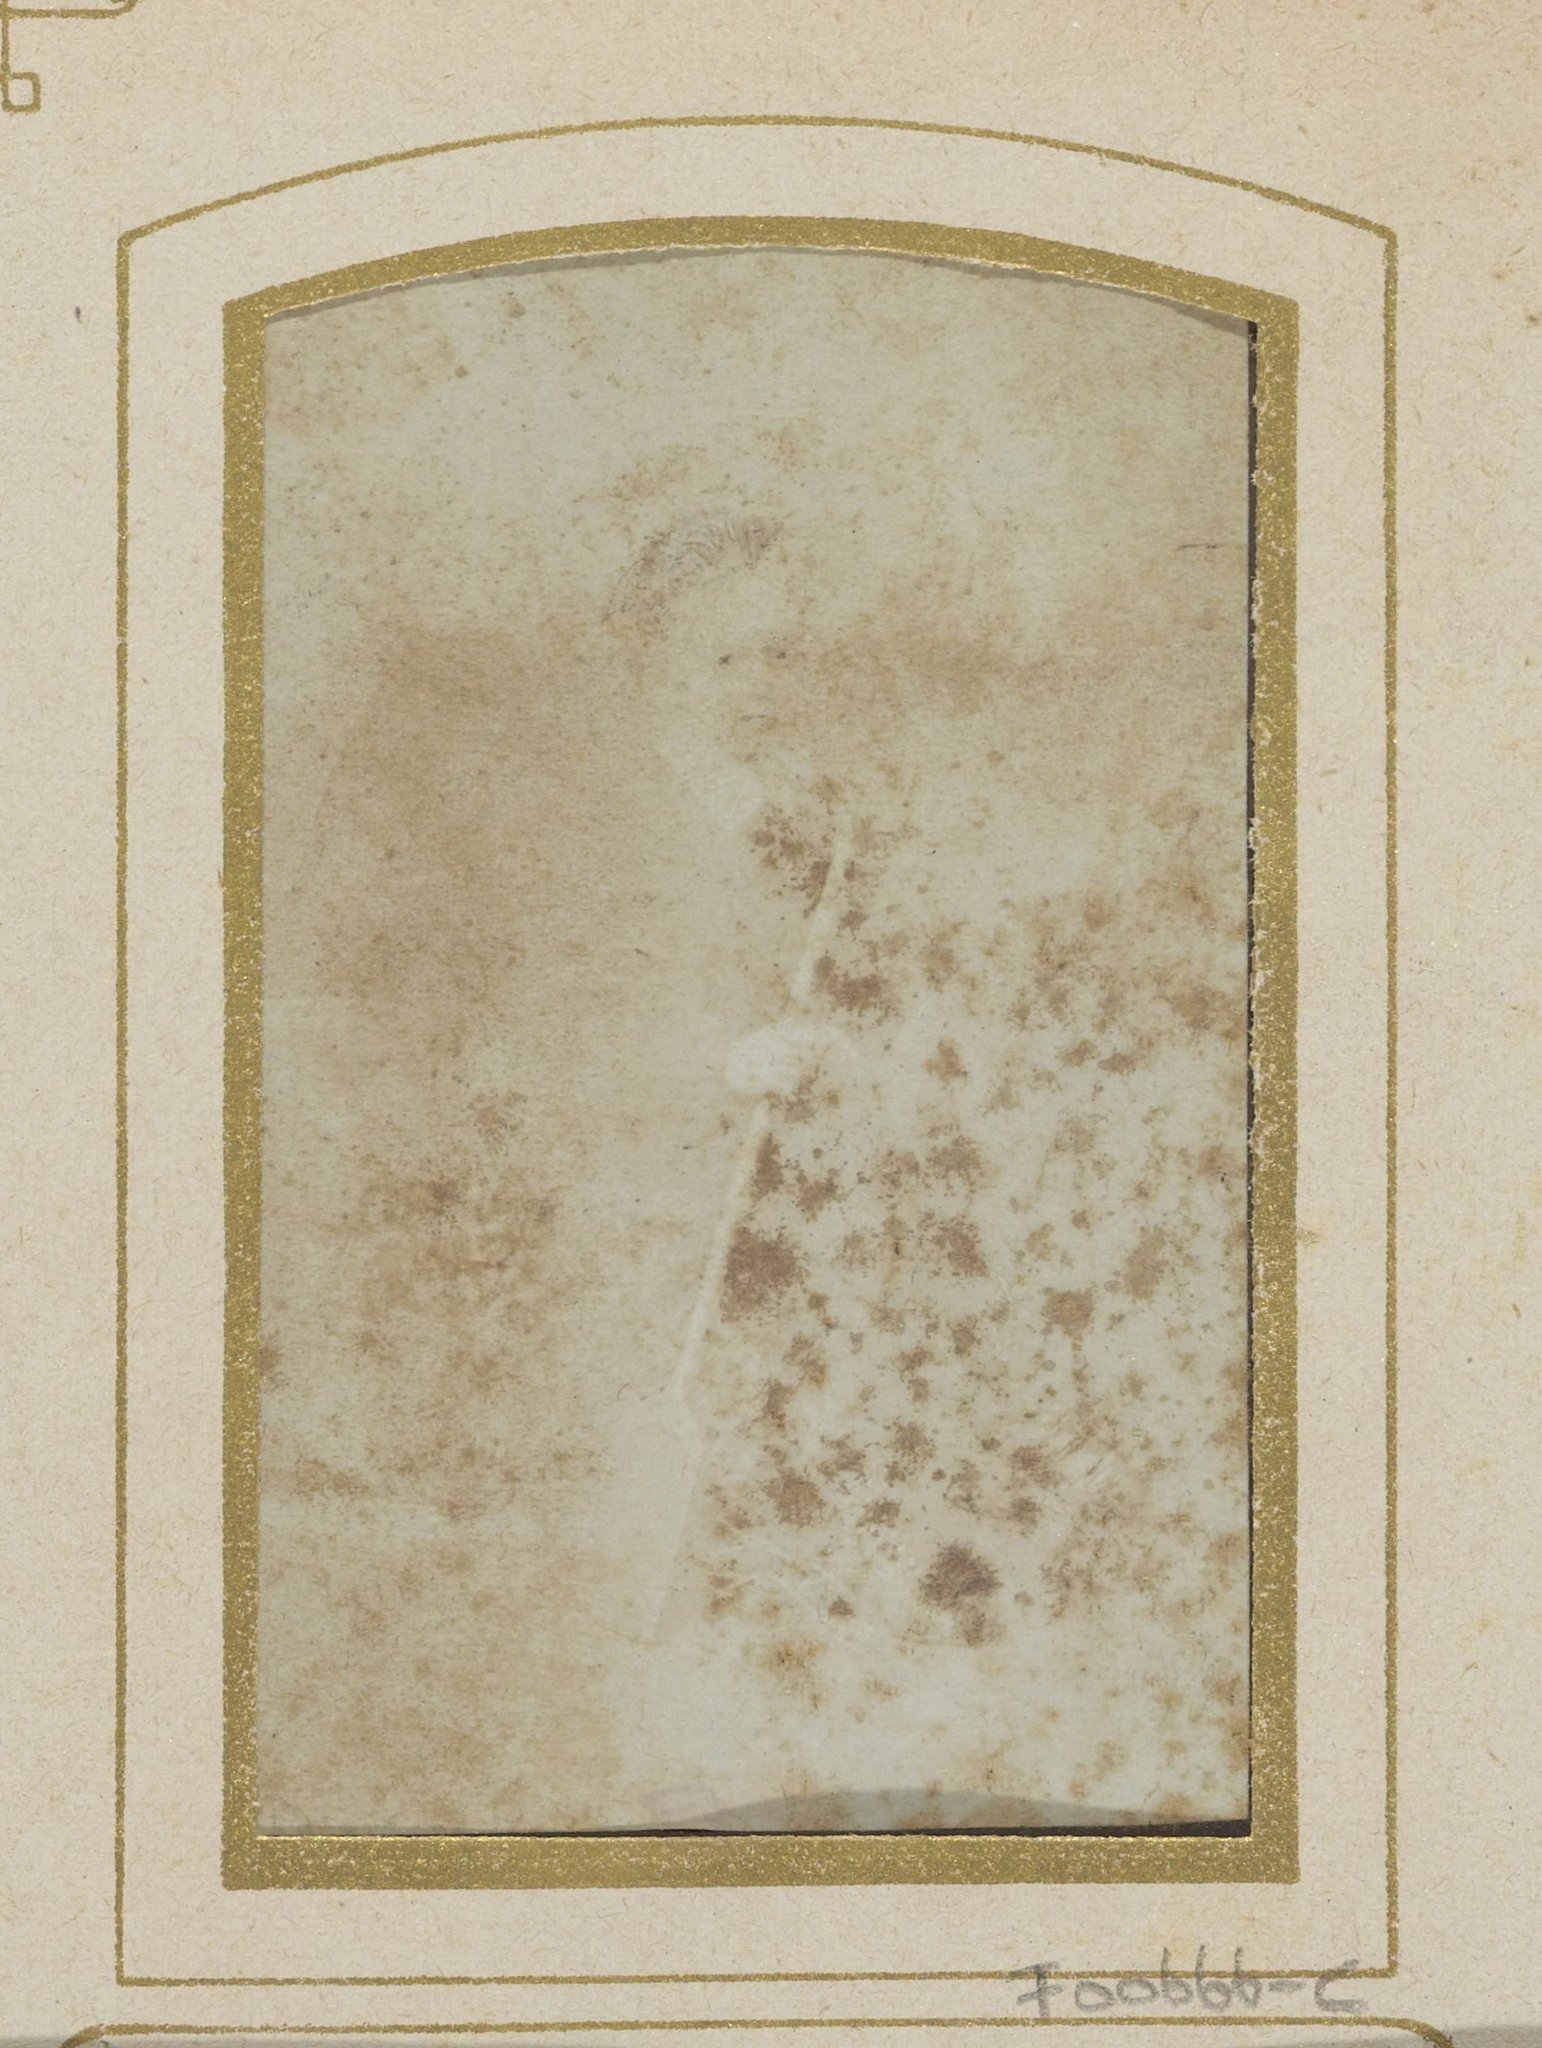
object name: album leaf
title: Portret van een jongen met schep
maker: johannes ephraim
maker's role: fotograaf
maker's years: 1838-1921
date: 1878-1900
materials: cardboard, photographic support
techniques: albumen print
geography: netherlands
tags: boy (child between toddler and youth), historical persons, agricultural implements: spade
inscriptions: inscription: ‘Specialite/ d'/ Agrandissements artistique/ (...)/ PHOT: ROYAL/ J. EPHRAIM/ Arnhem, Rynkade 53. Les clichés sont conservés.’